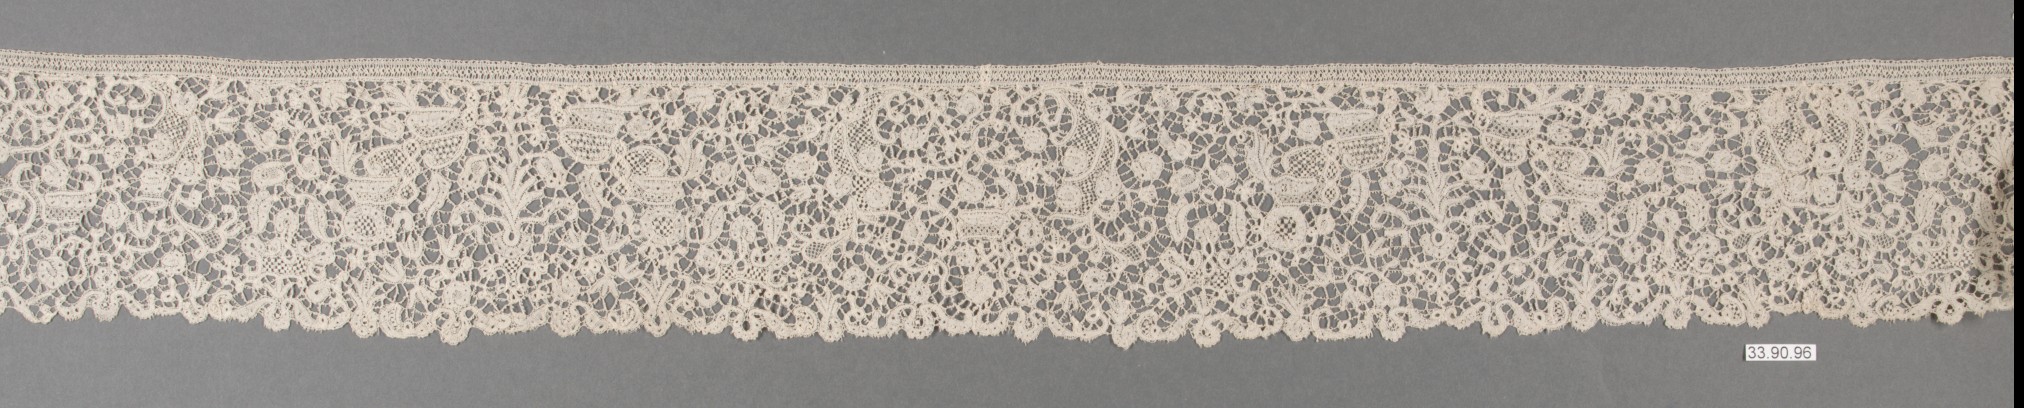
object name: edging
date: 1701-1733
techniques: lace